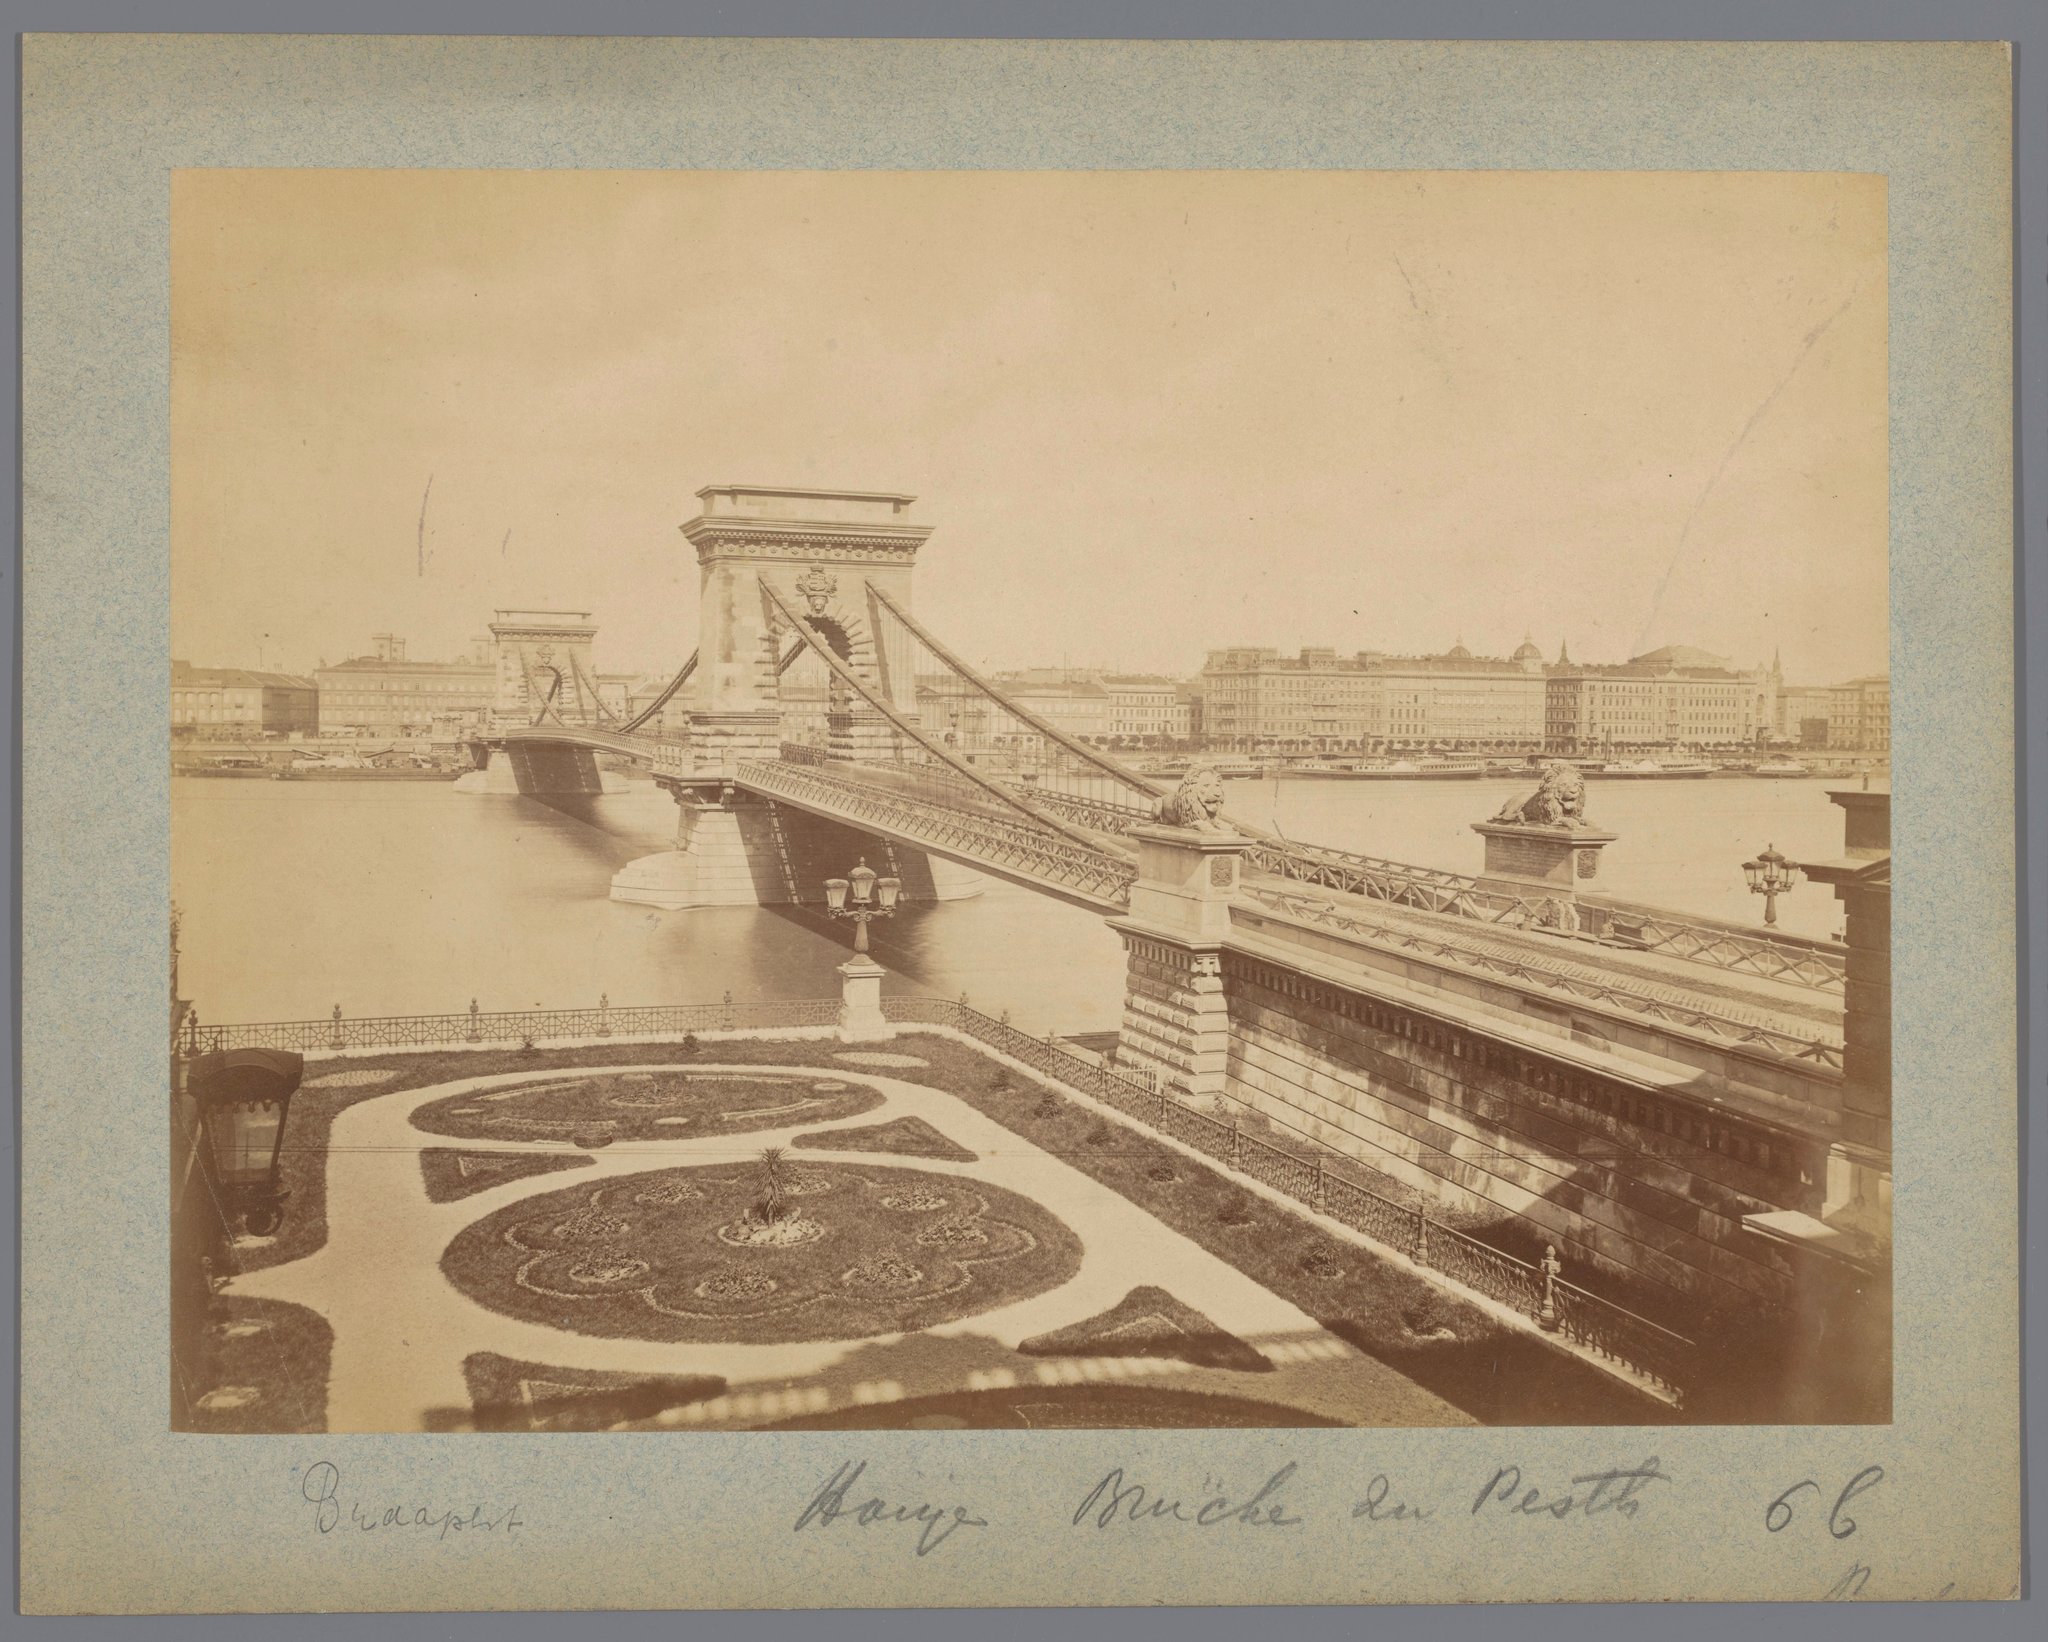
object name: photograph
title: Budapest, [...] Brücke du Pesth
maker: Anonymous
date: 1860-1900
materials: cardboard, paper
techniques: albumen print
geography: budapest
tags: bridge in city across river, canal, etc.